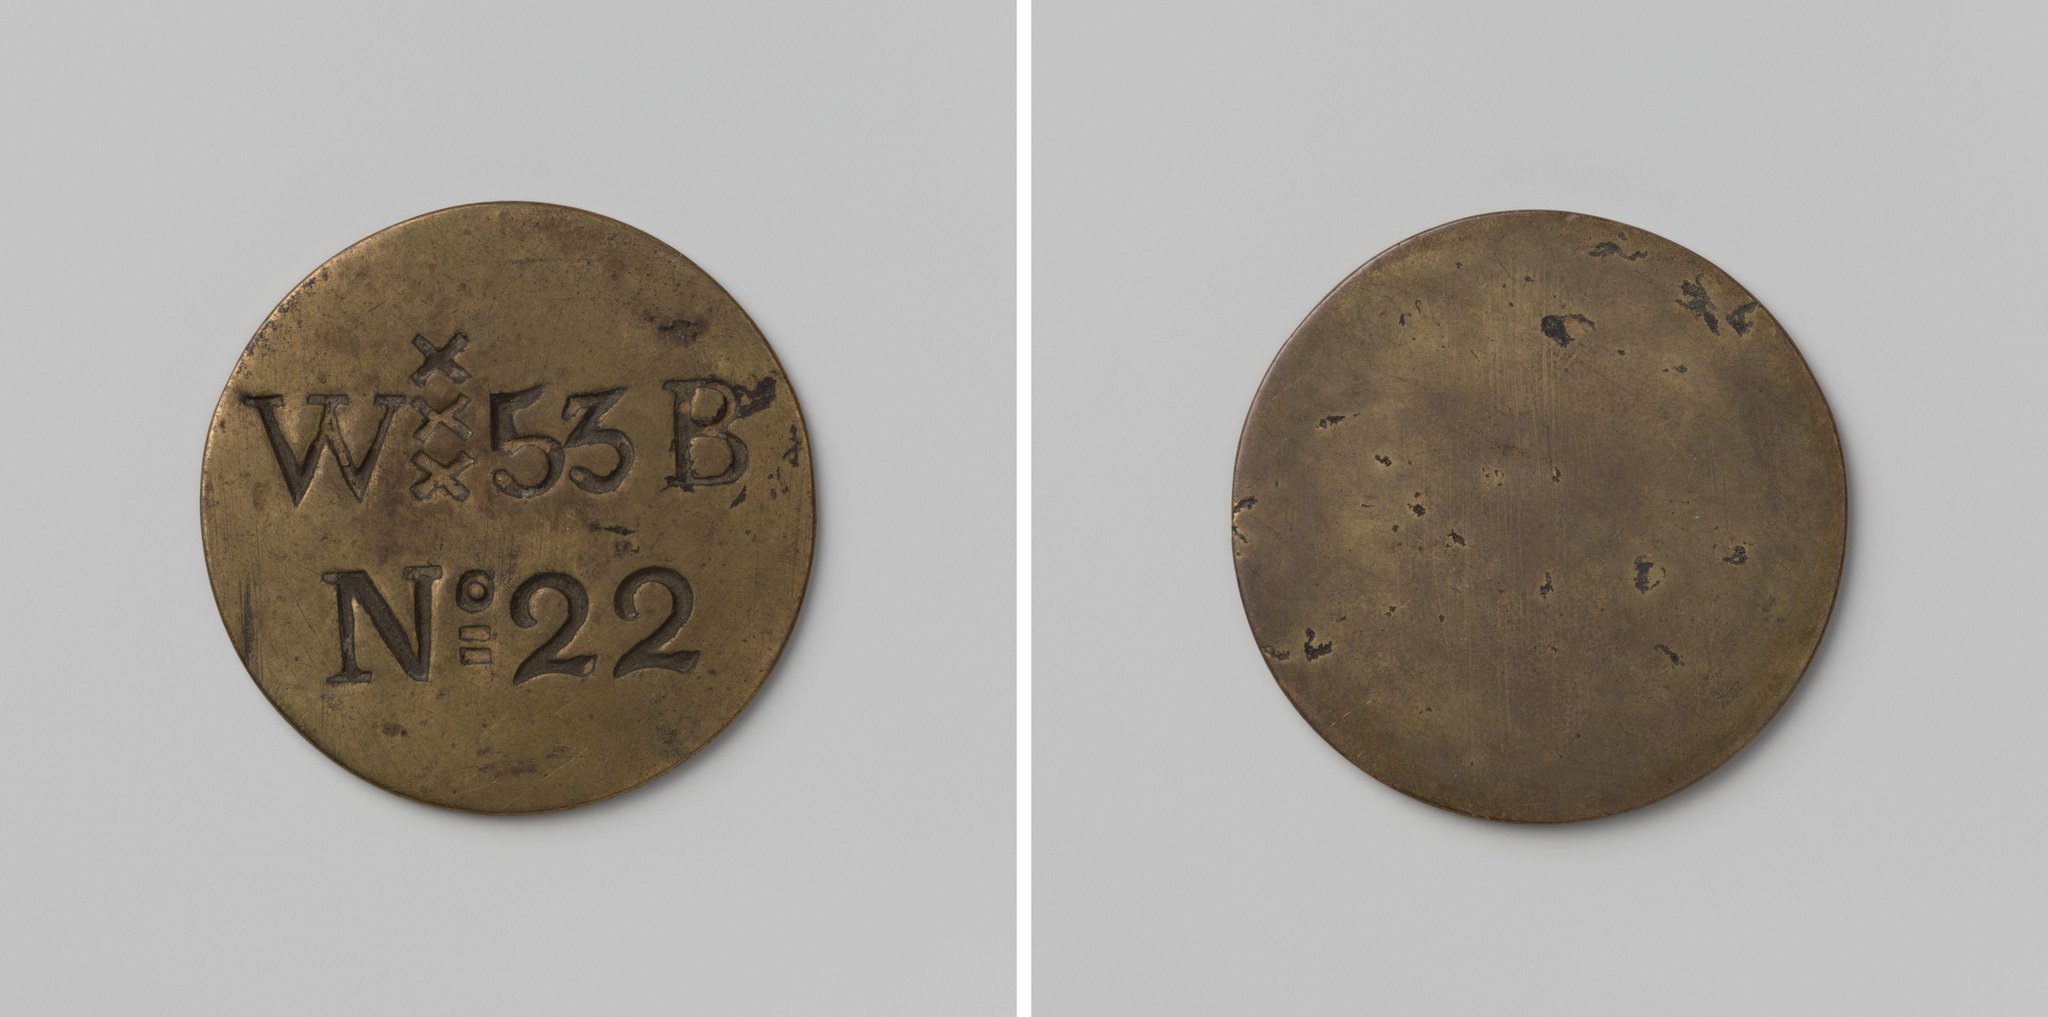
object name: medal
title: Amsterdam, brandspuitpenning van wijk 53 B met no. 22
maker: Anonymous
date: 1831-1857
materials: brass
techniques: engraving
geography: amsterdam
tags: amsterdam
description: Eenzijdige messing penning. Voorzijde: opschrift W 53 B, onderbroken door drie boven elkaar geplaatste kruisjes; daaronder: opschrift No. 22. Keerzijde: blanco